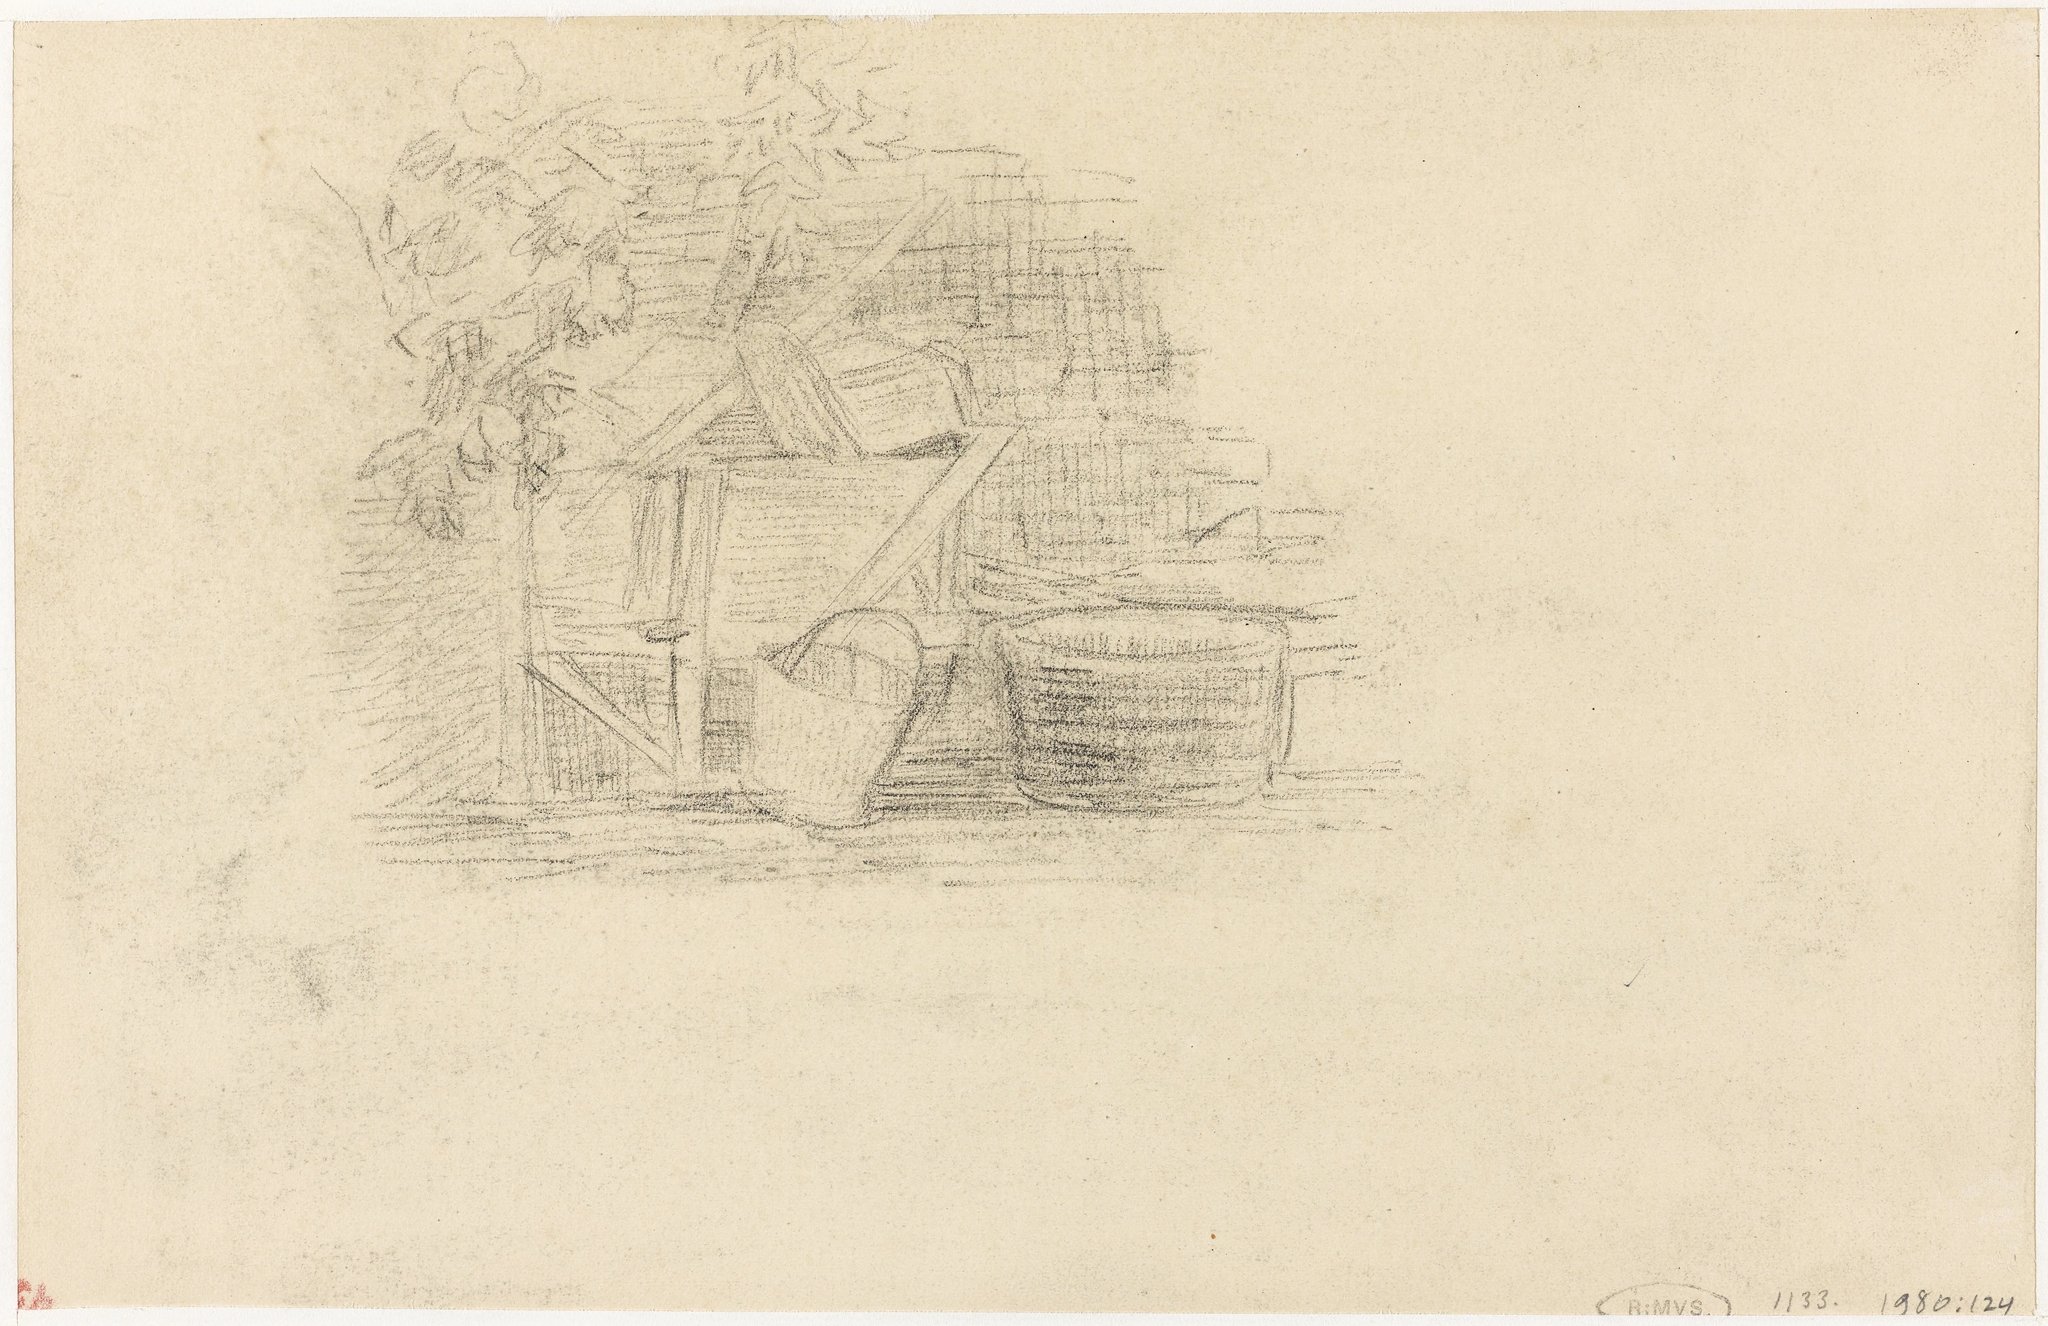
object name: drawing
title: Stilleven van gereedschap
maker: jozef israëls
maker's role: draughtsman, painter, print maker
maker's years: 1824-1911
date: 1834-1911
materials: chalk, paper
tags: still life of related objects